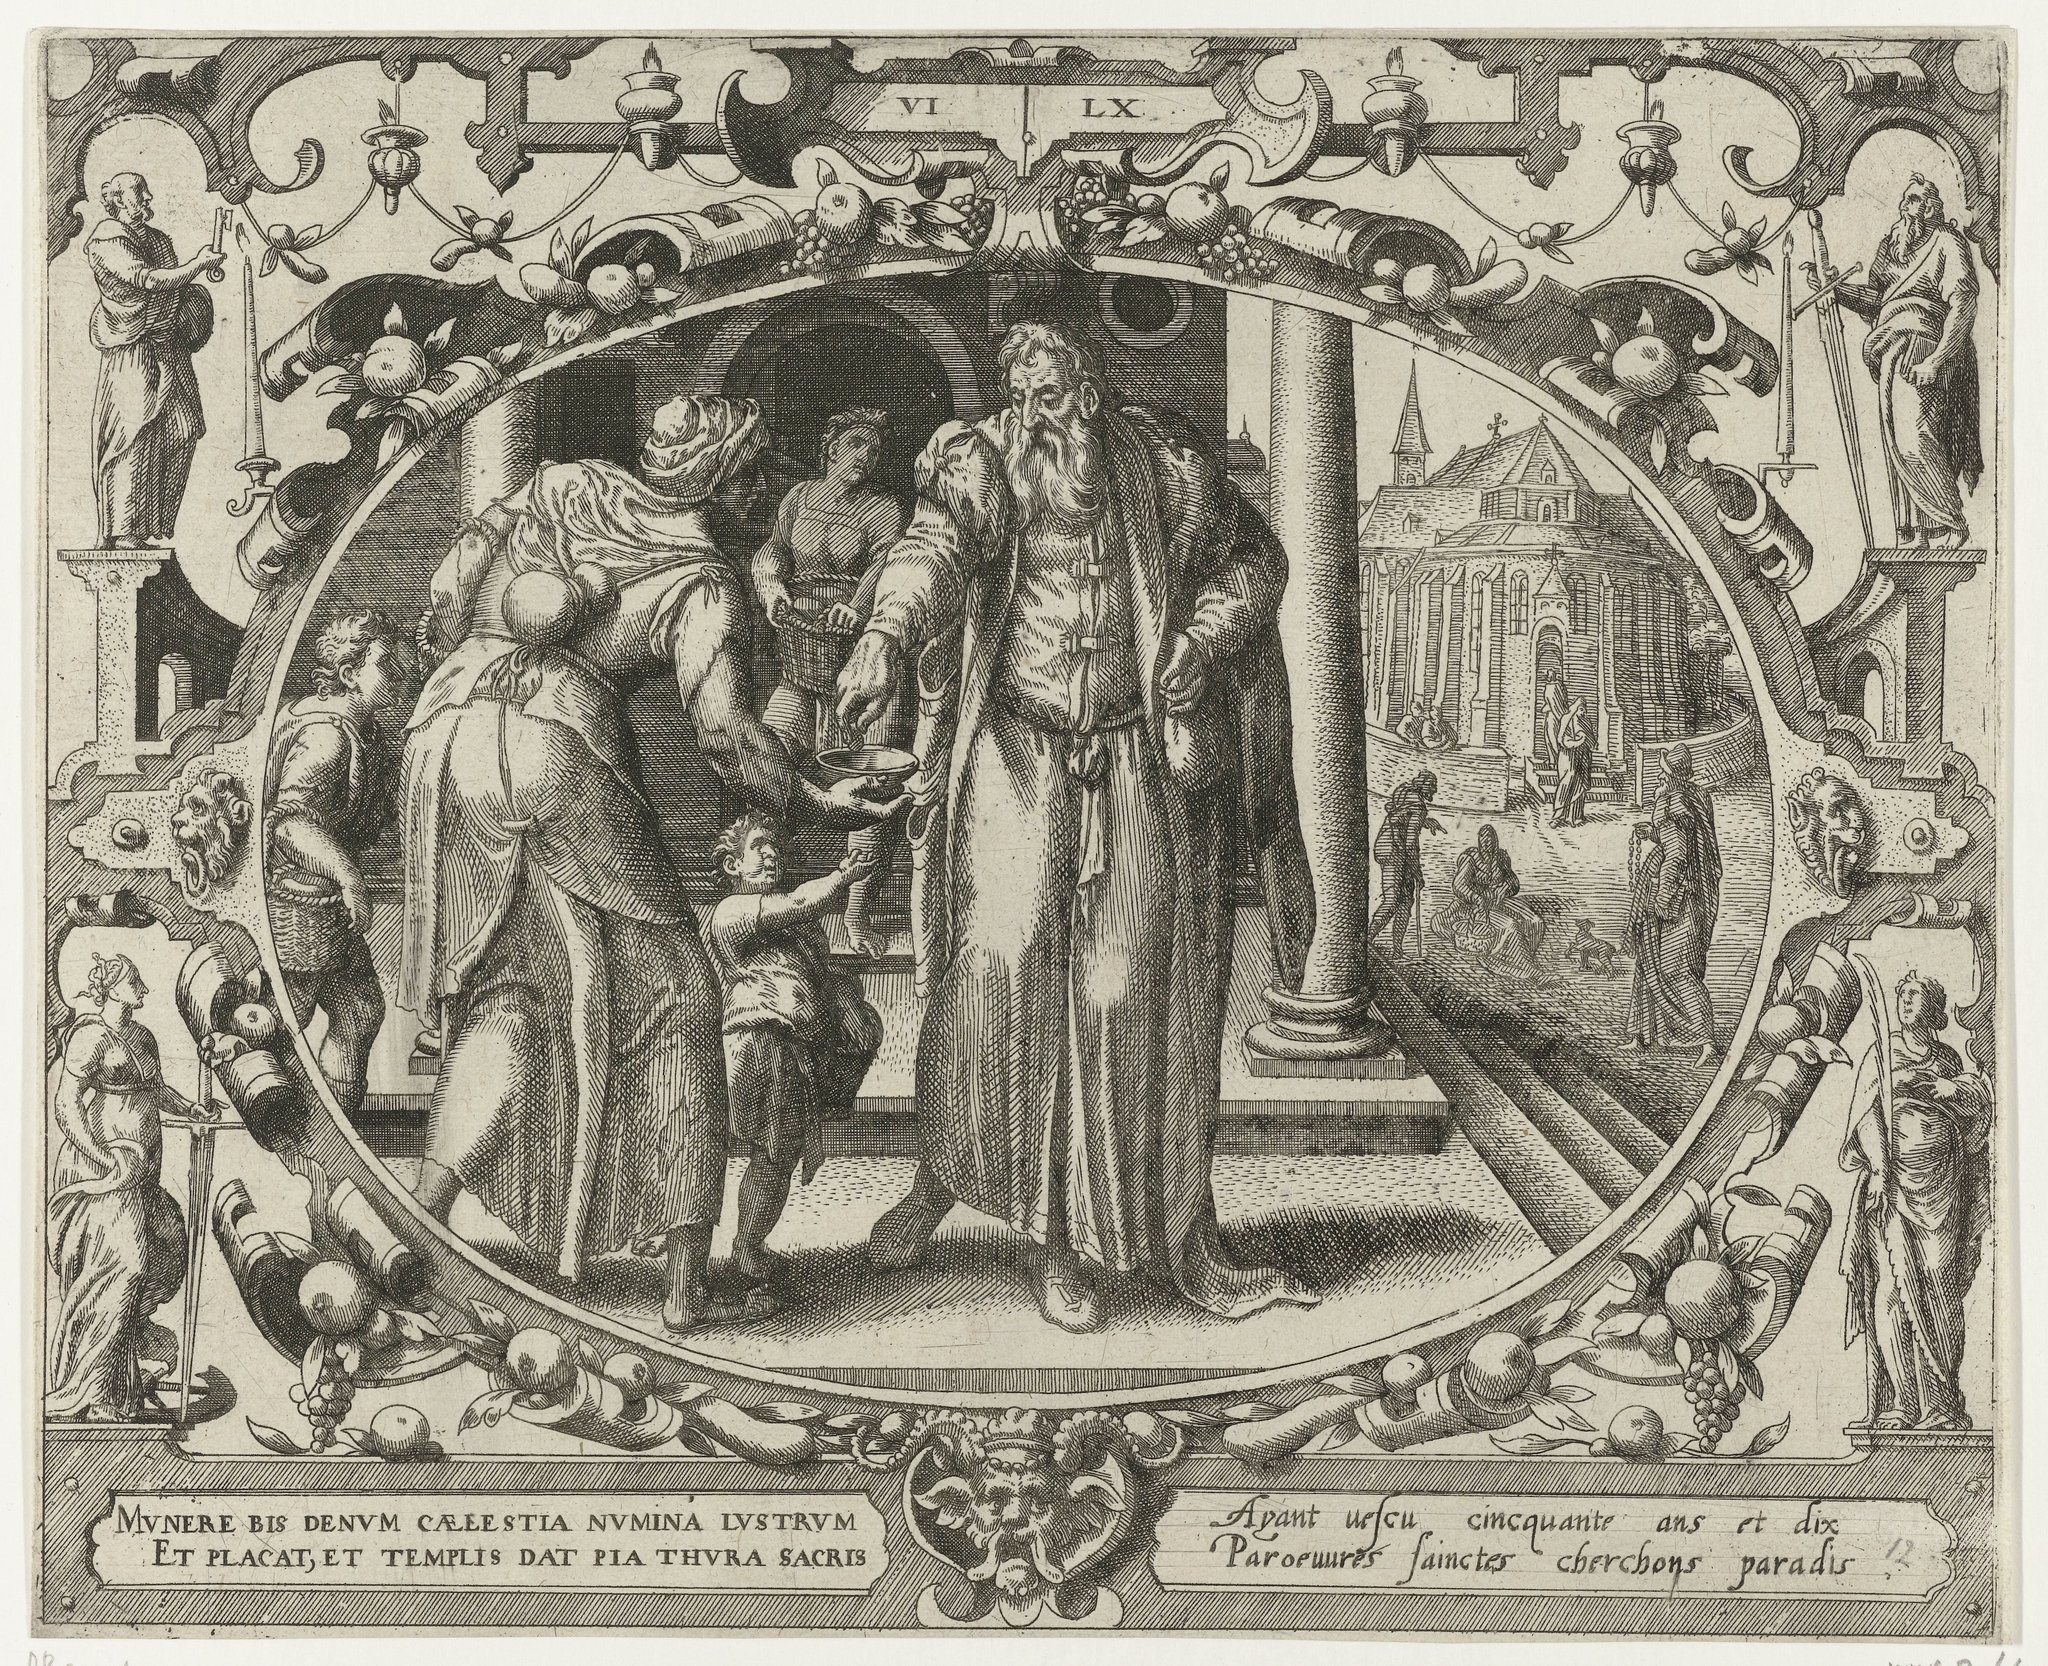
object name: print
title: De mens op zestigjarige leeftijd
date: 1569-1575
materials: paper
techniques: engraving, etching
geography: antwerp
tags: giving alms or other charity, e.g.: handing out food, old man, roman catholic church, beggar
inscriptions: collector's mark: Lugt 2228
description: In een ovaal kader versierd met ornamenten een voorstelling van een oudere man die een aalmoes geeft aan een bedelares. Op de achtergrond een kerk. De prent heeft een Latijns en Frans onderschrift.